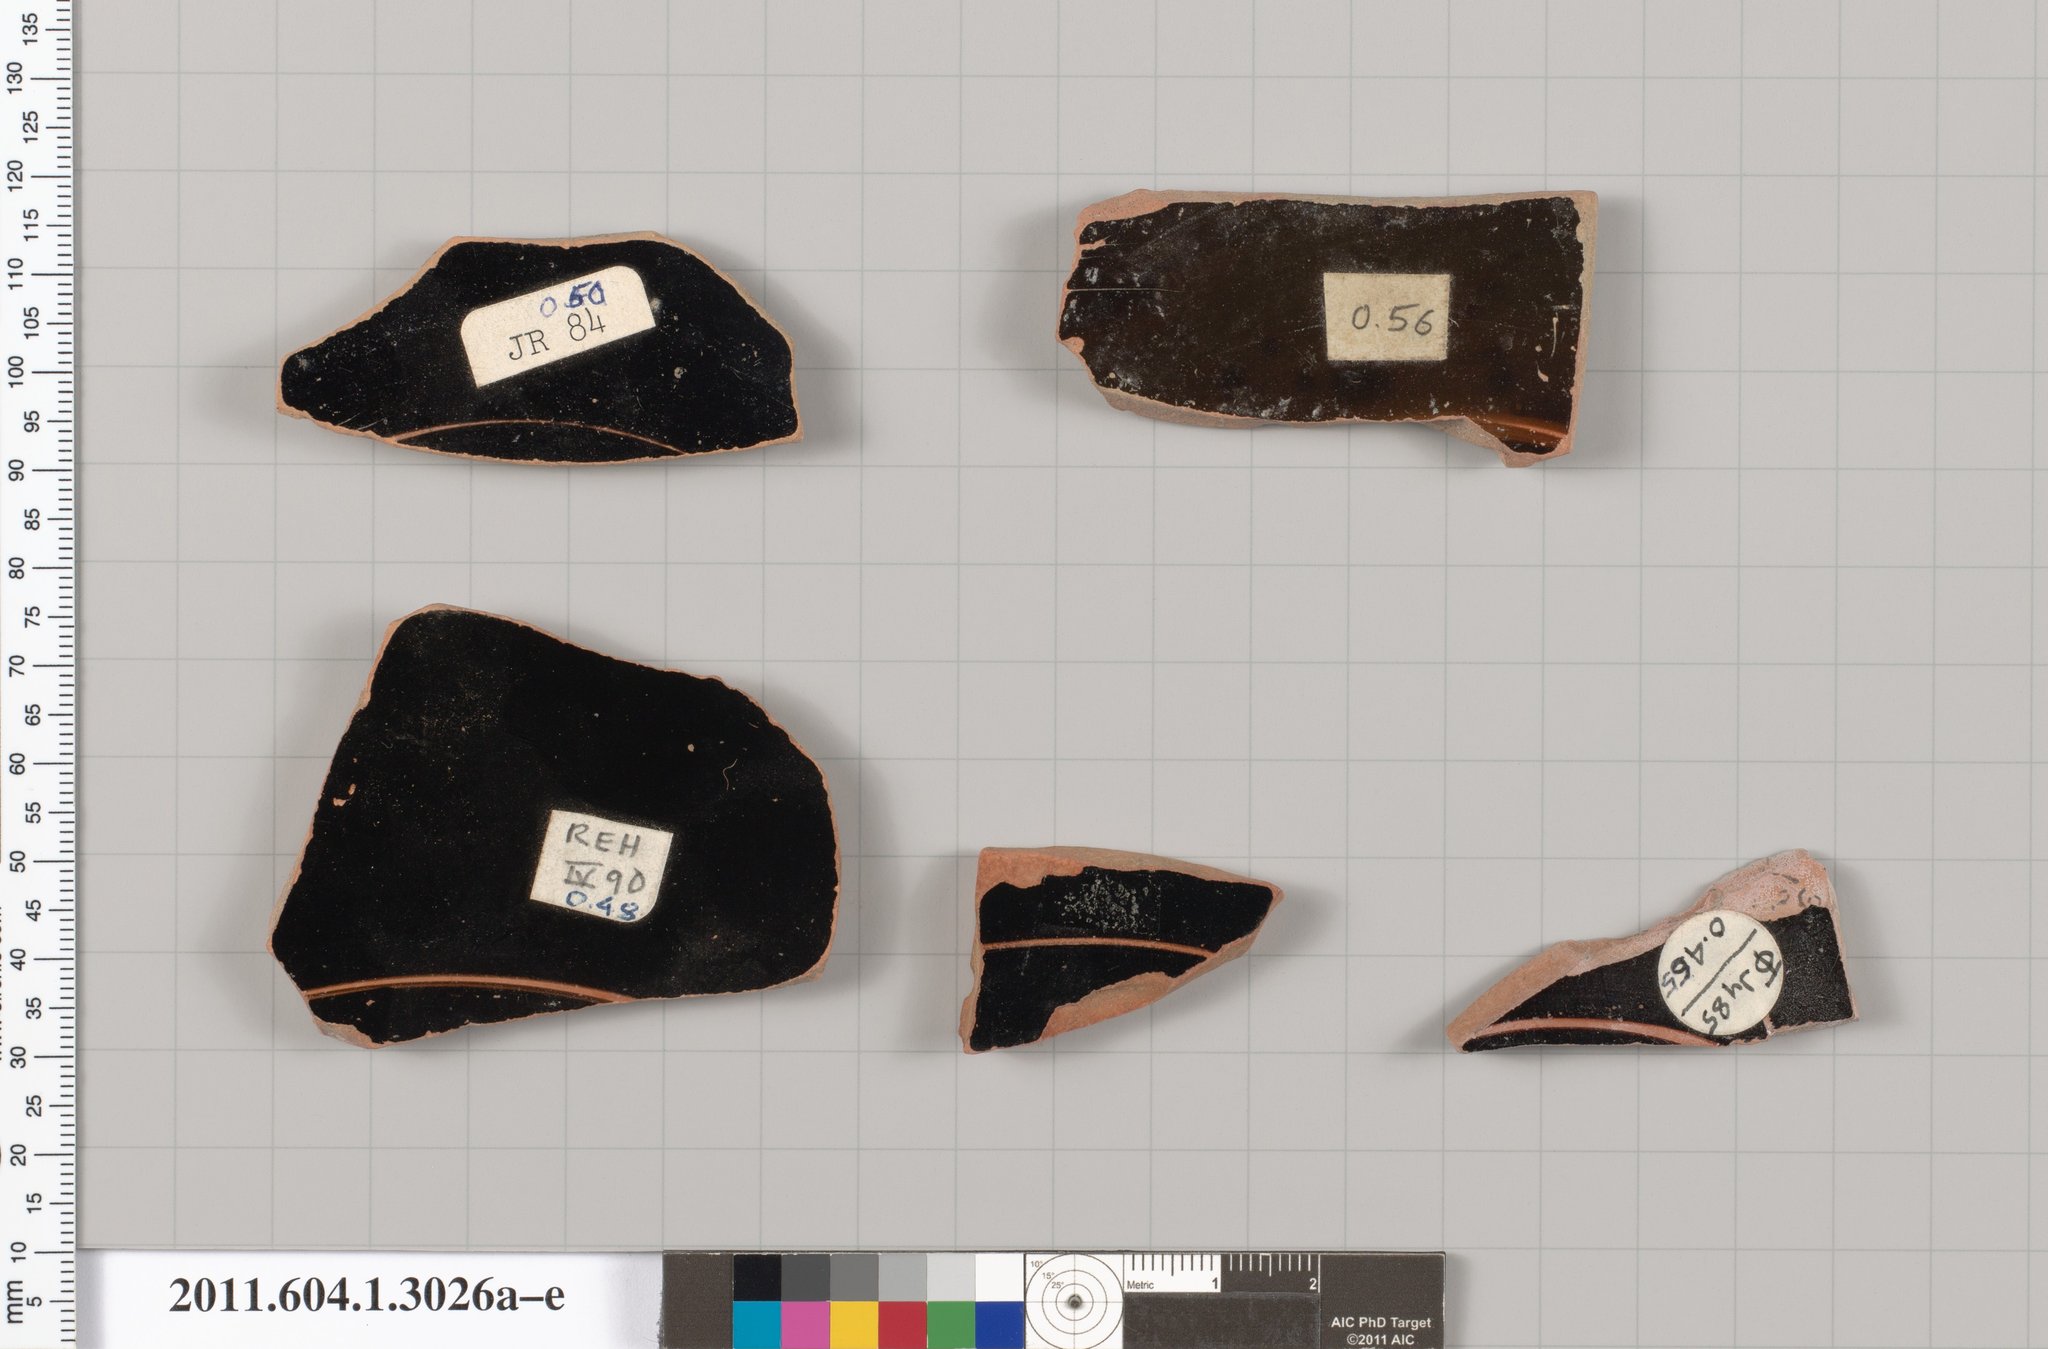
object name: kylix fragment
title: Terracotta fragments of kylikes (drinking cups)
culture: greek, attic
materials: terracotta